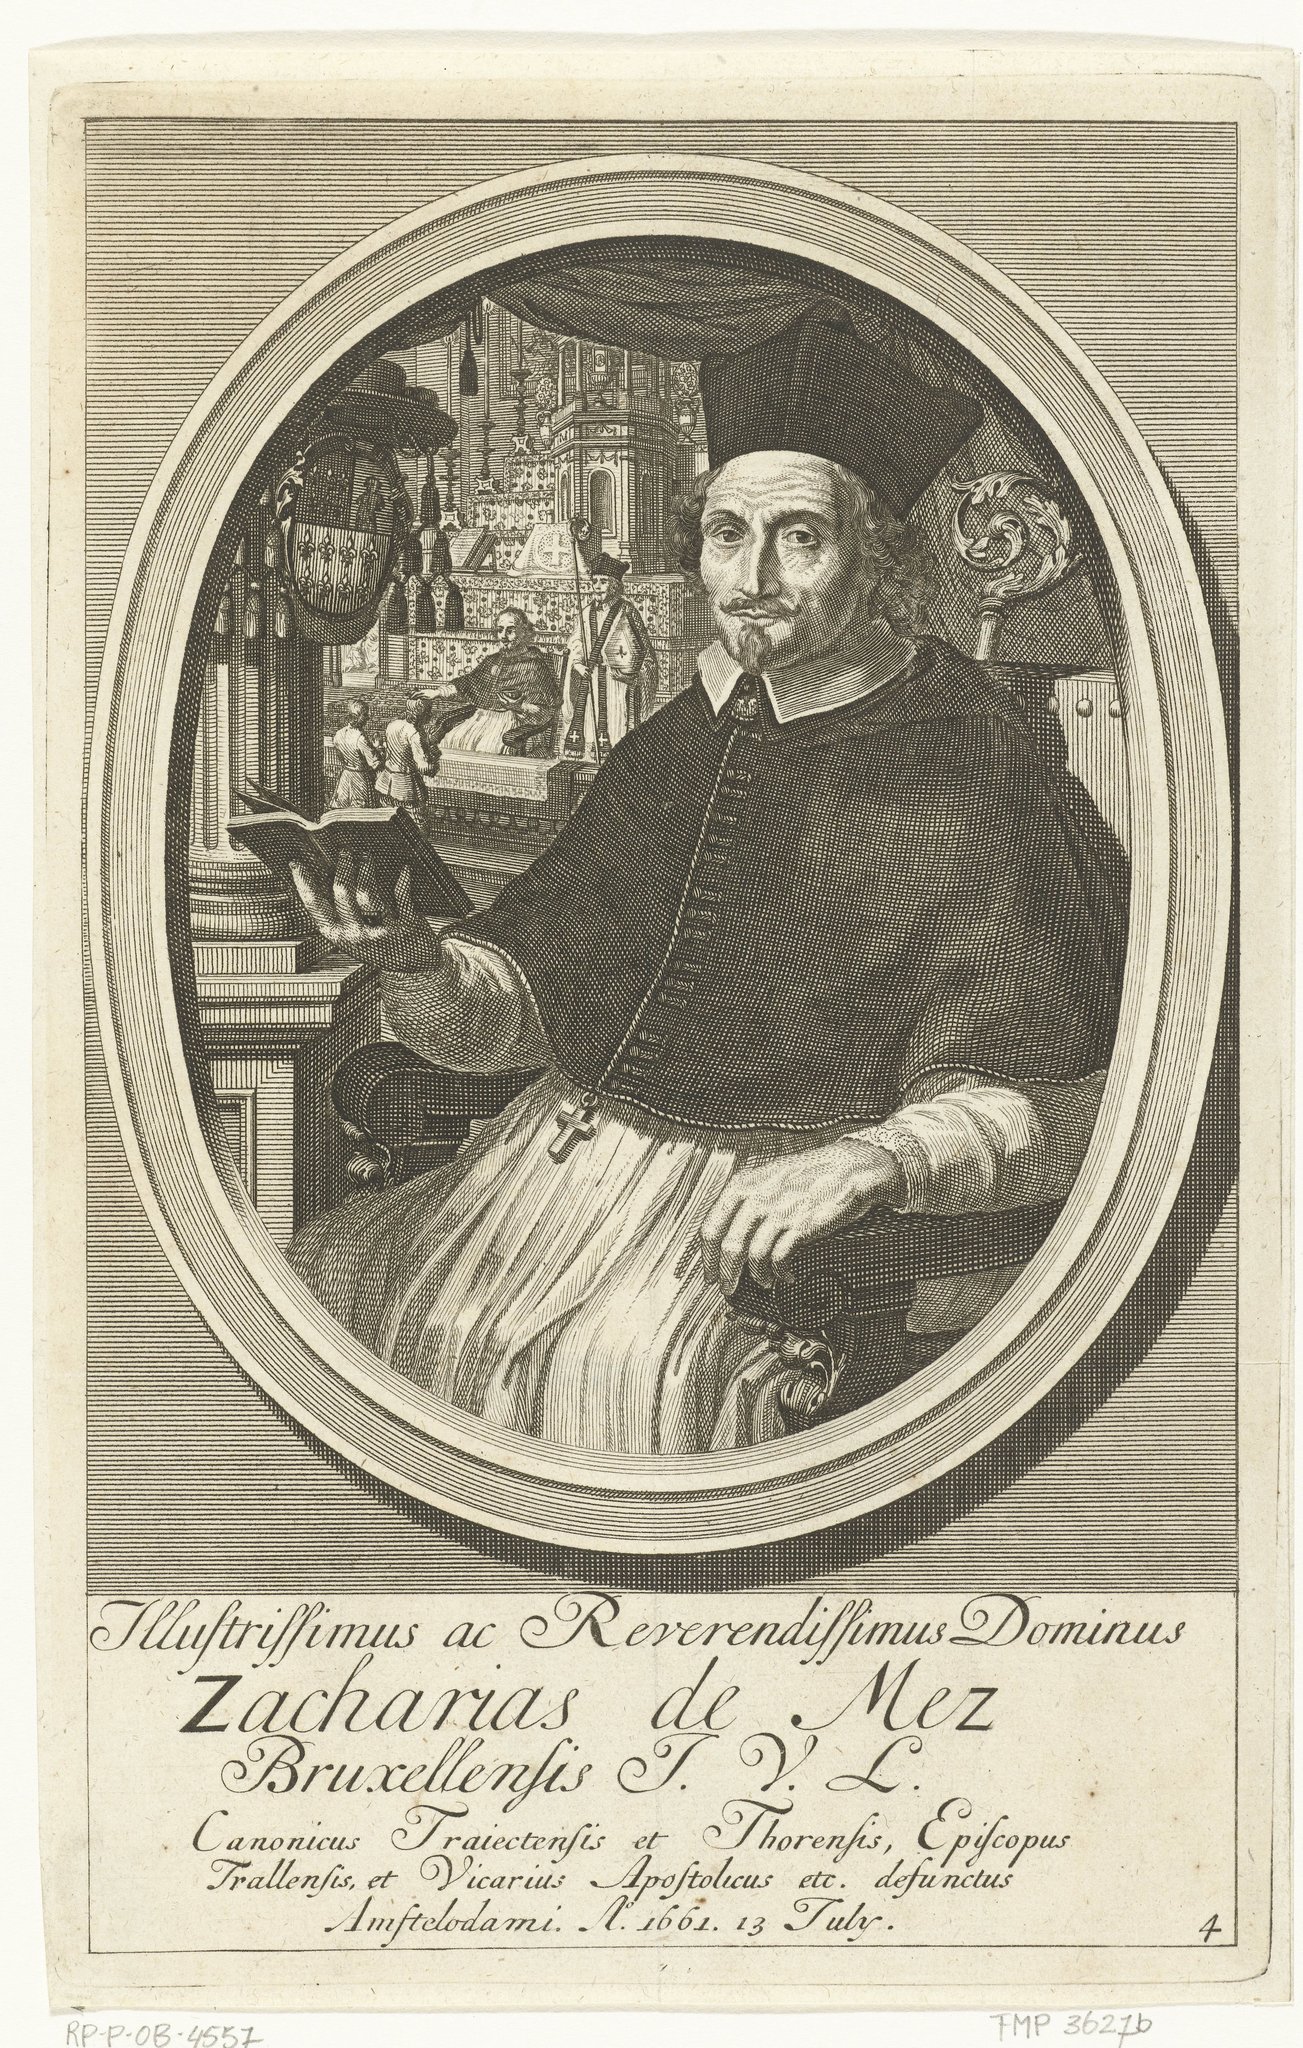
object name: print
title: Illustrissimus ac Reverendissimus (...) Amstelodami Ao 1661 13 July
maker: françois van bleyswijck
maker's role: draughtsman, print maker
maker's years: 1671-1746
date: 1681-1726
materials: paper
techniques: engraving, etching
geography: leiden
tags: archbishop, bishop, etc. (roman catholic)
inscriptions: collector's mark: Lugt 2228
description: Prent later gebruikt in: Heussen, Hugo Franciscus van & Hugo van Rijn, Kerkelijke historie en outheden der Zeven Vereenigde Provincien, 6 delen, Leiden, Dirk Haak & Samuel Luchtmans & Johan Arnold Langerak, 1726.